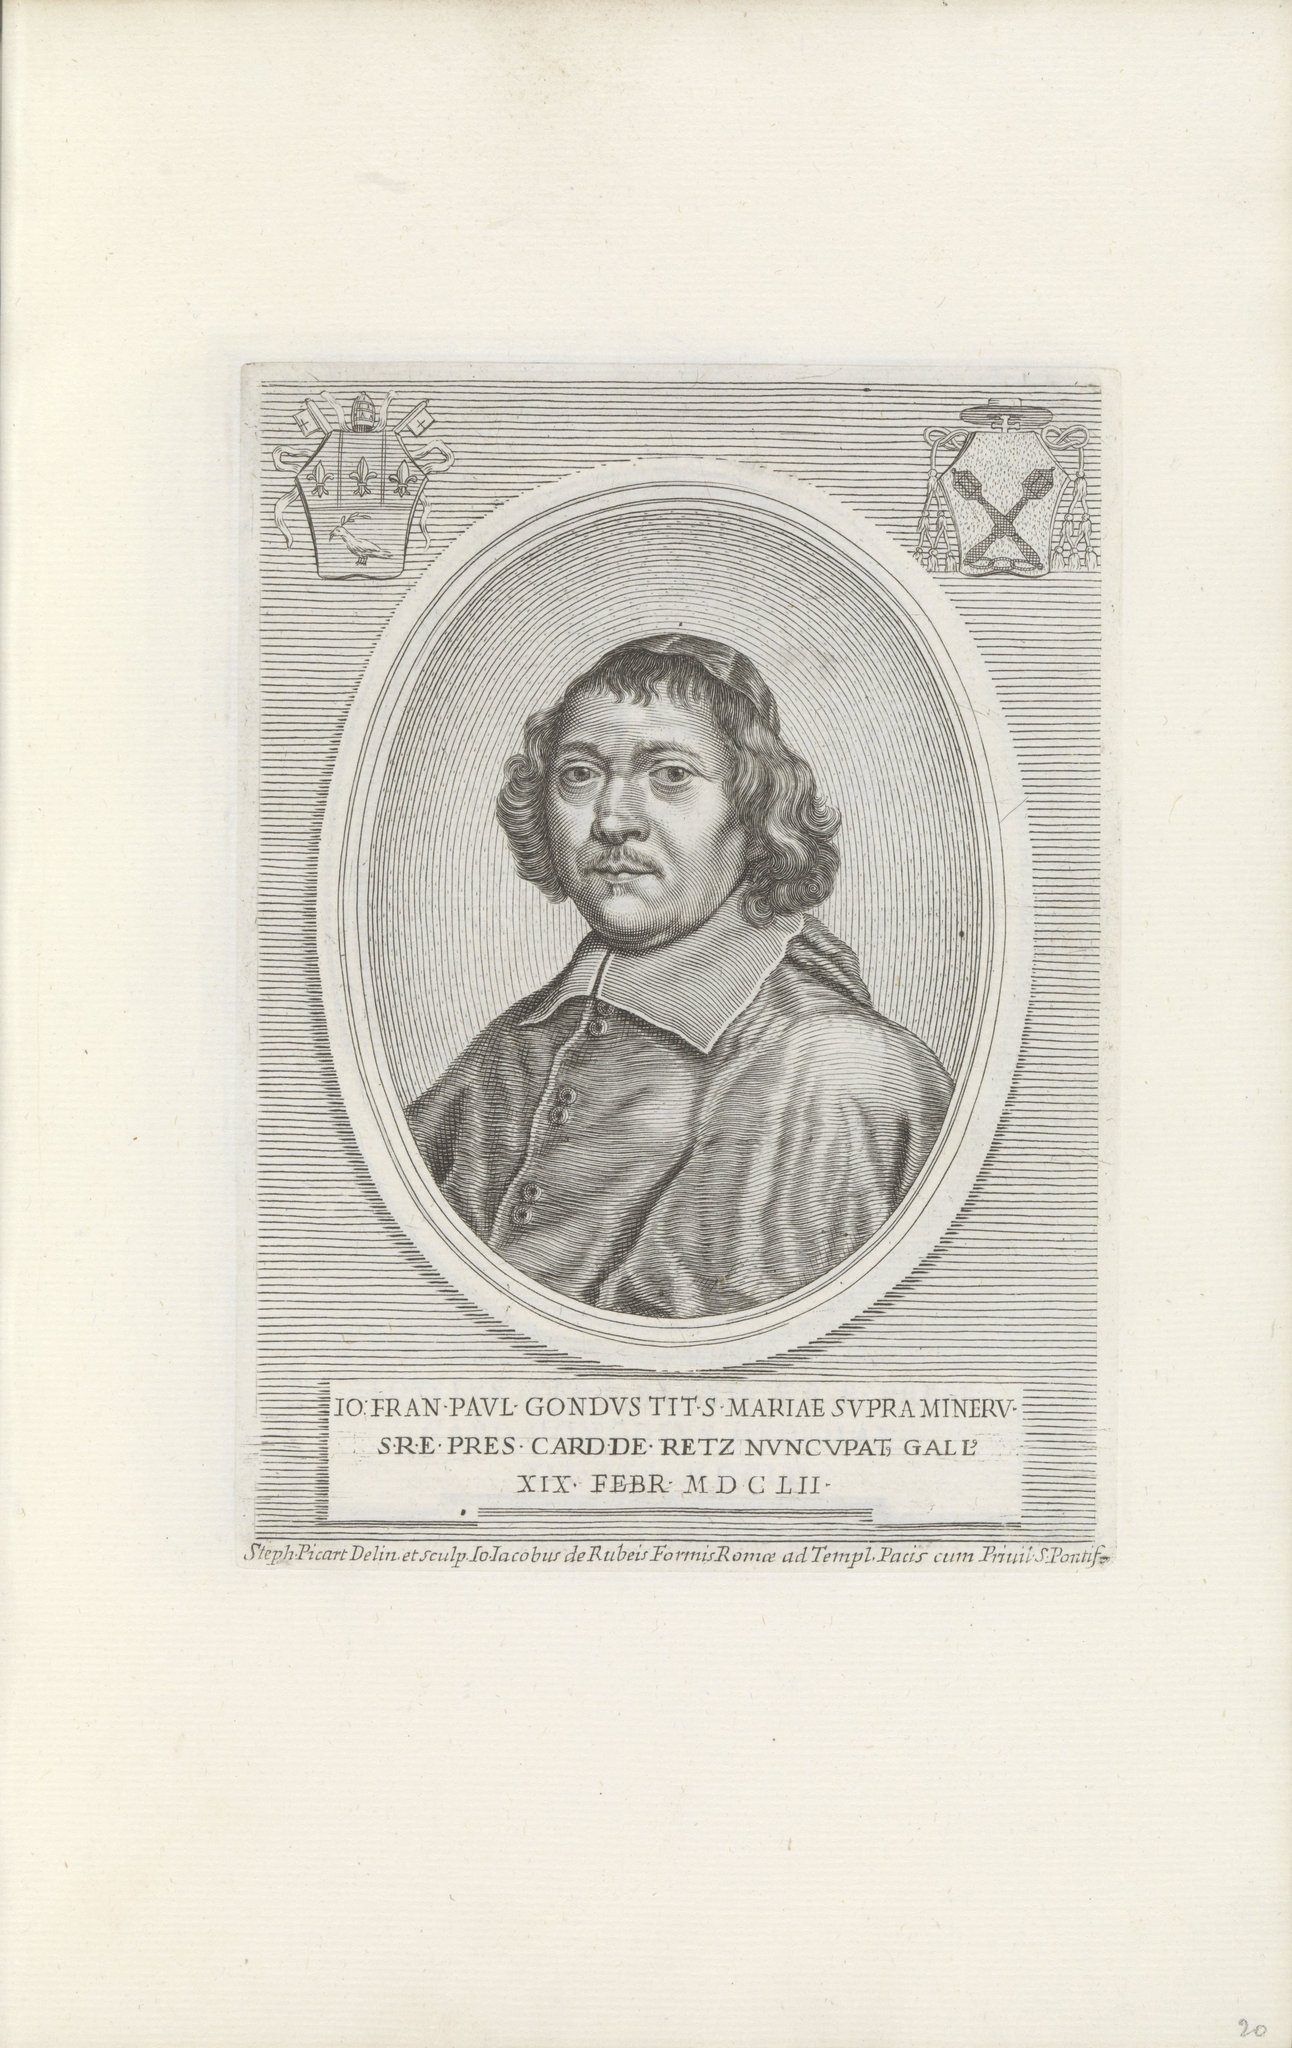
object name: album leaf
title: Portret van kardinaal Jean-François-Paul de Gondi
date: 1658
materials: paper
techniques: engraving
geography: rome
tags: cardinal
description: Portret van kardinaal Jean-François-Paul de Gondi. Linksboven het wapen van paus Innocentius X en rechtsboven het wapen van de kardinaal. Onderaan een onderschrift in het Latijn. De prent maakt deel uit van een album.